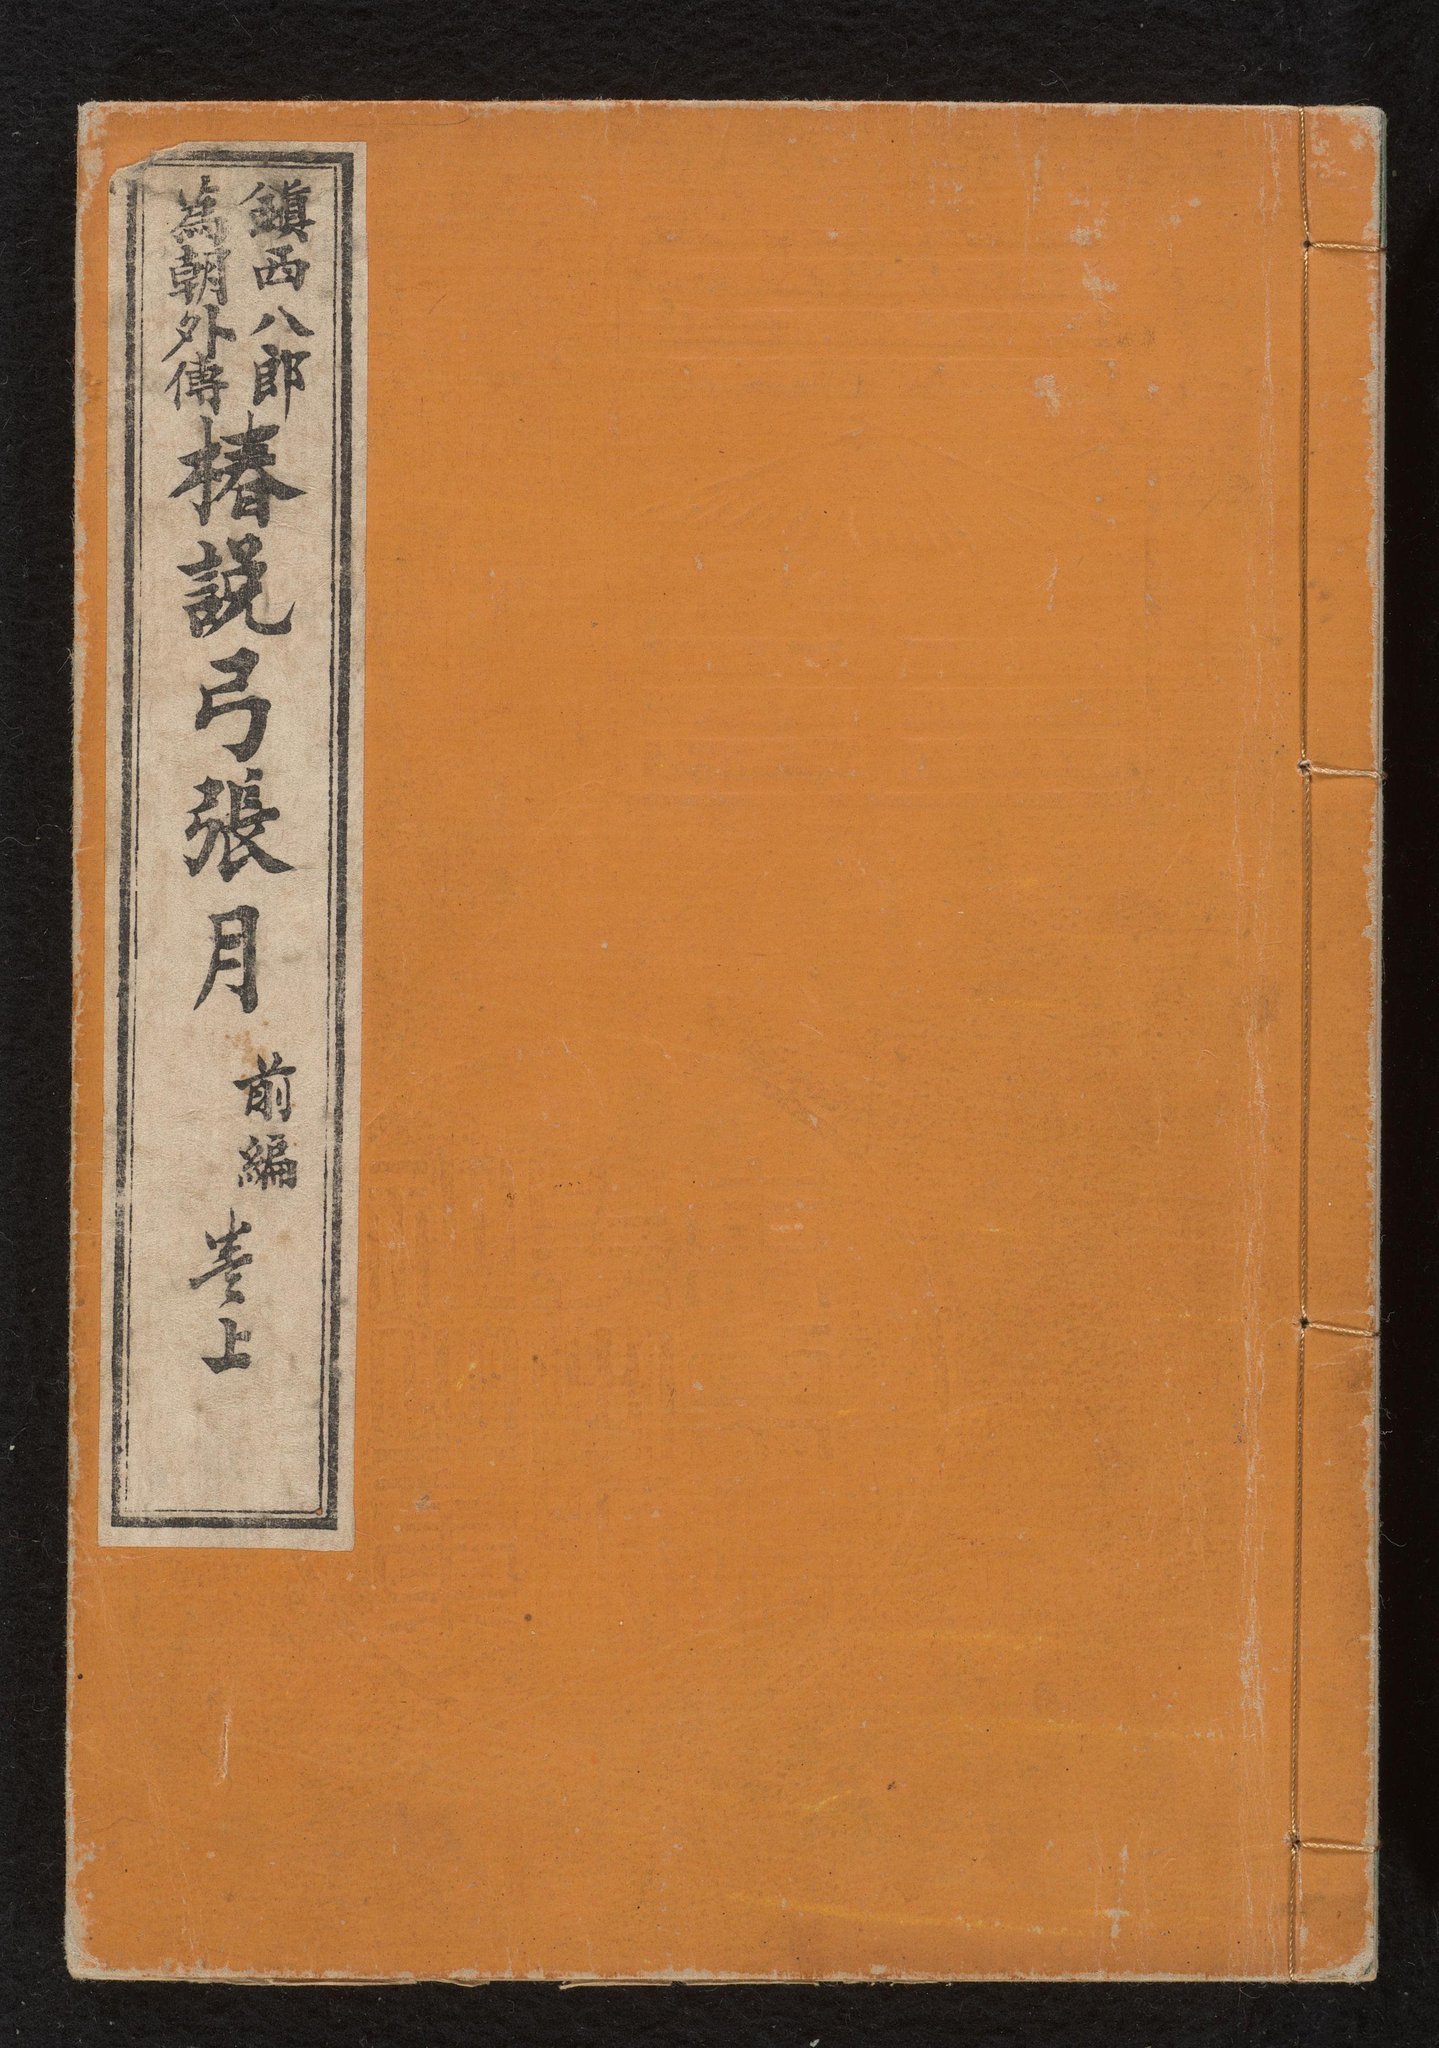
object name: book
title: De avonturen van Tametomo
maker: tsukioka yoshitoshi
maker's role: print maker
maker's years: 1839-1892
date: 1883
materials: paper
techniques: blind stamped, lithograph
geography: japan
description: Boek uit een tiendelige serie over de avonturen van de legendarische strijder Tametomo, geïllustreerd met 26 prenten gesigneerd door Tsukioka Yoshitoshi. De prenten zijn uitgevoerd in een combinatie van houtsnede en lithografie en gedrukt in zwart met een grijs toonblok. In originele banden met blinddruk.